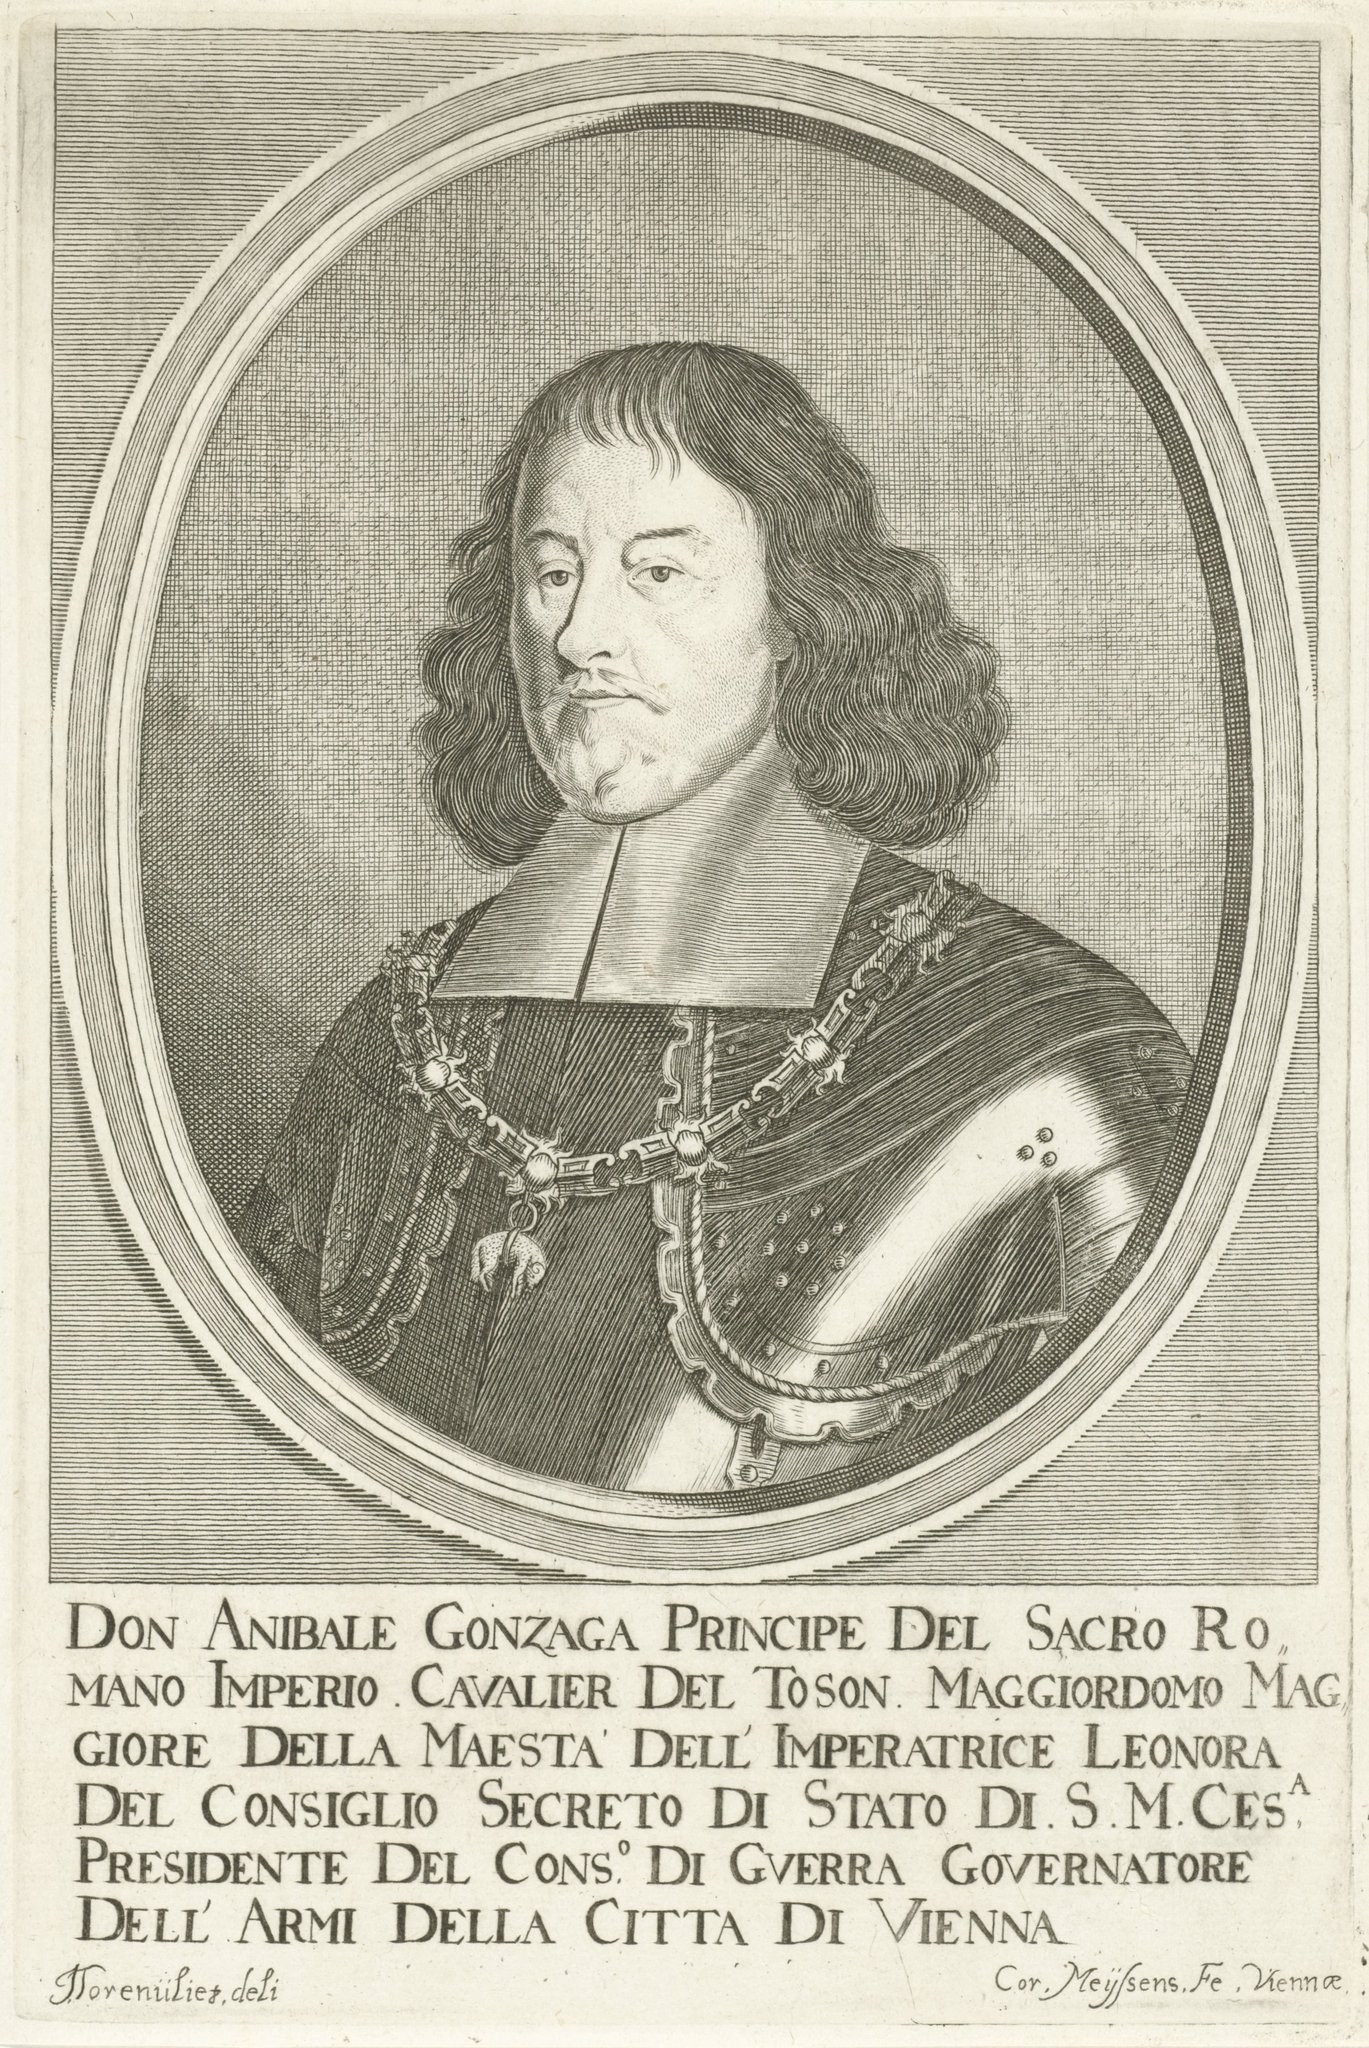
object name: print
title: Portret van Annibale Gonzaga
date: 1670-1674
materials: paper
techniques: engraving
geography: vienna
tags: knighthood order of the golden fleece - insignia of a knighthood order, e.g.: badge, chain (with name of order)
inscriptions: collector's mark: Lugt 2228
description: Portret van Annibale Gonzaga, commandant van Wenen, met de ordeketen van de Orde van het Gulden Vlies om zijn hals. Onderaan in de marge zijn titels in het Italiaans.